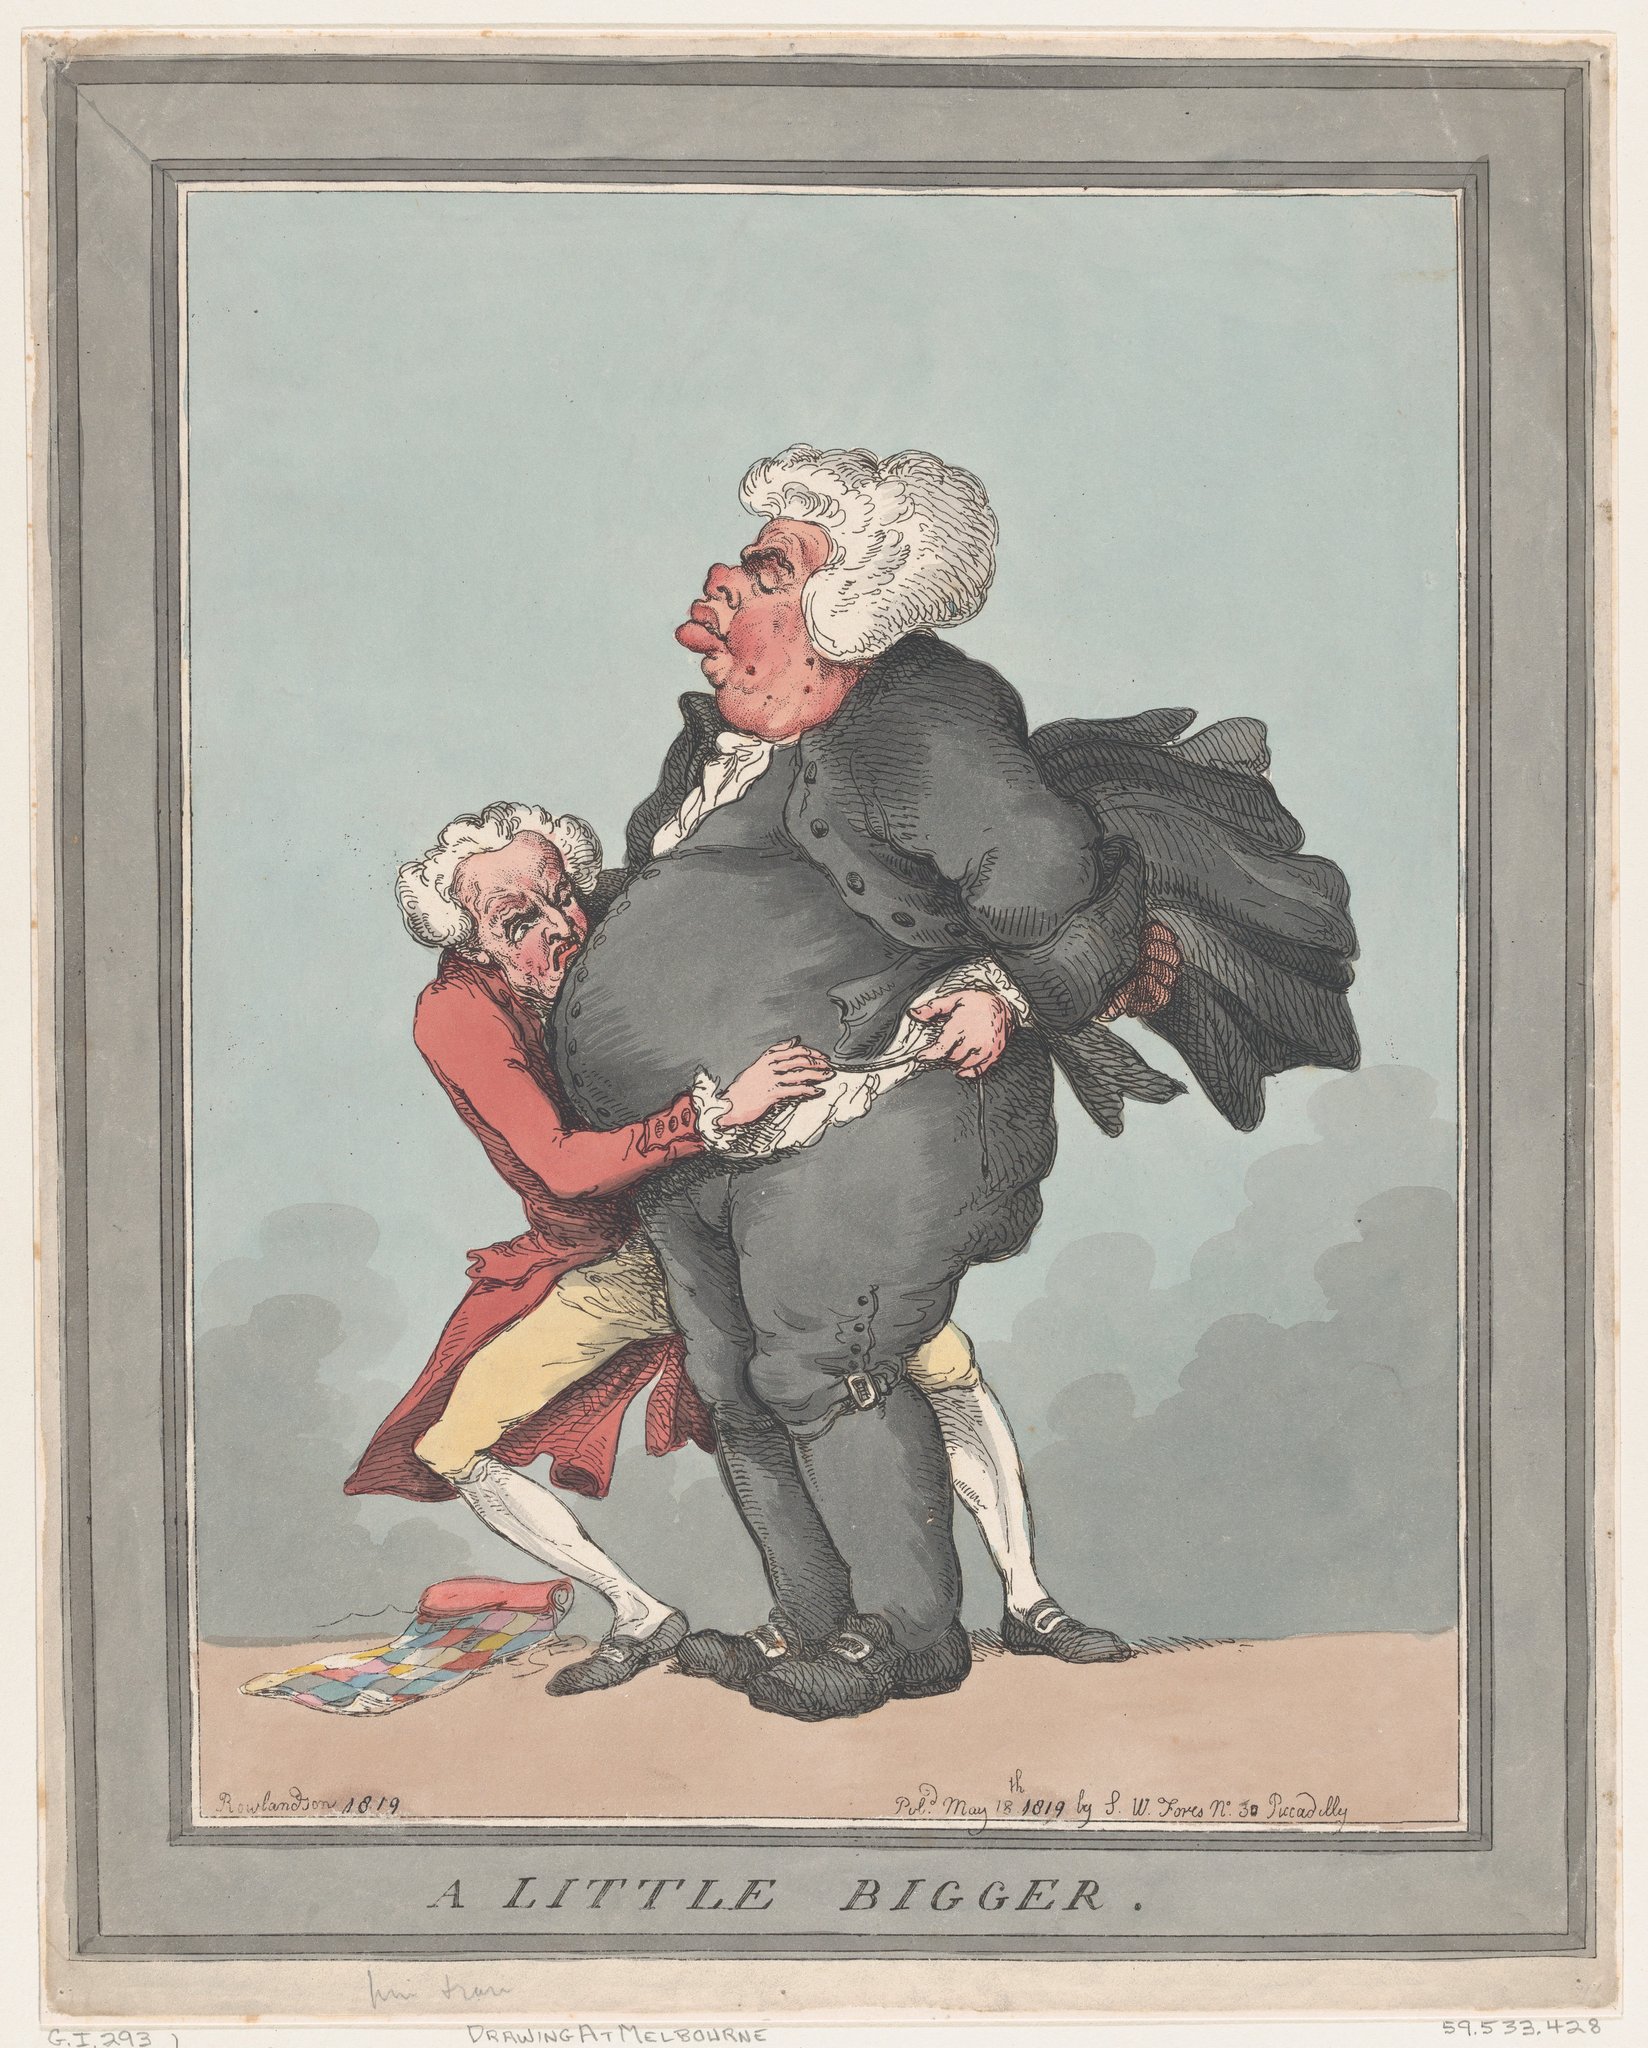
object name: print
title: A Little Bigger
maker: thomas rowlandson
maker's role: artist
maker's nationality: british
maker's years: 1757-1827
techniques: etching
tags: satire,men